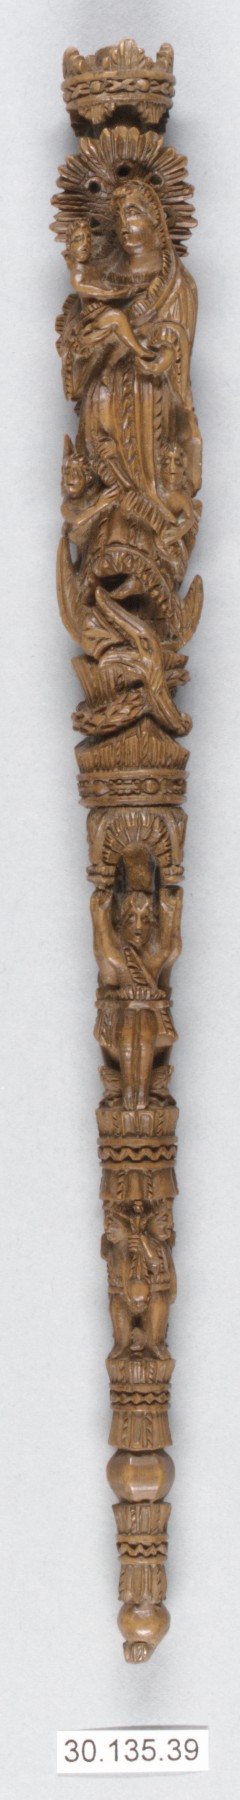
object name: needle sheath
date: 1601-1700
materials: wood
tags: madonna and child